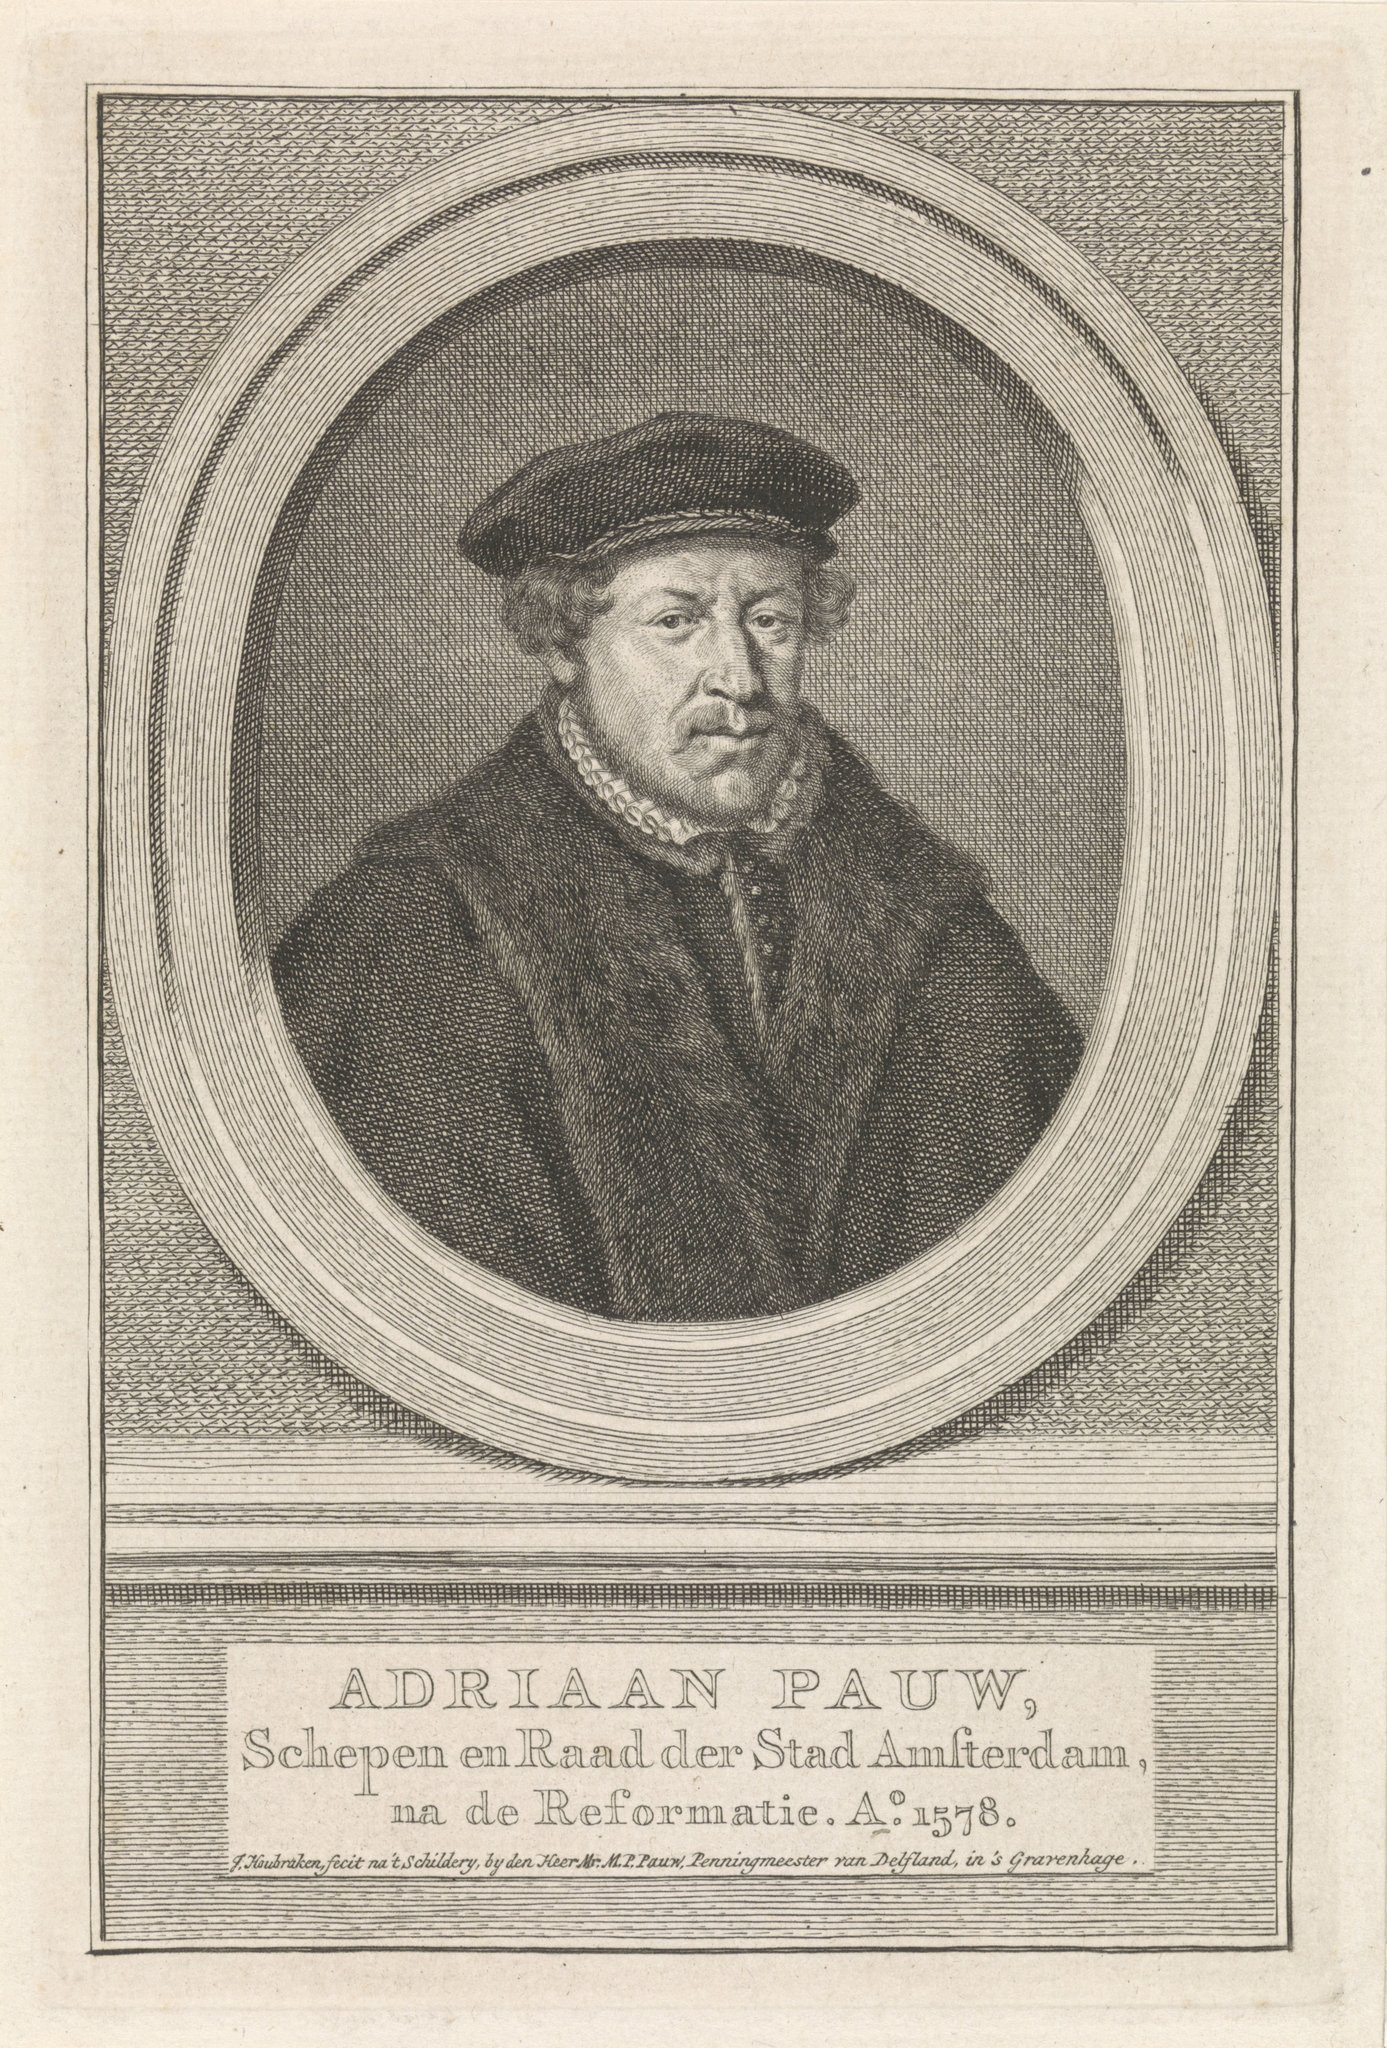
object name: print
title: Portret van Adriaan Pauw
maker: jacob houbraken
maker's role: draughtsman, print maker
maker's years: 1698-1780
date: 1749-1780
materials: paper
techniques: engraving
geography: amsterdam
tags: historical persons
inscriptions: collector's mark: Lugt 2228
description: Deze prent is oorspronkelijk bedoeld als aanvulling op Jan Wagenaars ‘Vaderlandsche historie’* en was zo vanaf 1796 verkrijgbaar bij Johannes Allart te Amsterdam. Voor de advertentie waarin Allart de 60 portretten en 7 platen, allen gegraveerd door Houbraken, ter aanvulling op Wagenaars ‘Vaderlandsche historie’ aanbiedt, zie RP-P-OB-77.766. *Van dit werk zijn in de achttiende eeuw meerdere uitgaves verschenen, zoals: Wagenaar, Jan. Vaderlandsche historie, vervattende de geschiedenissen der Vereenigde Nederlanden (…). 21 delen. Amsterdam: Isaak Tirion, 1749-1759. Wagenaar, Jan. Vaderlandsche historie, vervattende de geschiedenissen der nu Vereenigde Nederlanden (…). 21 delen. Amsterdam: weduwe Isaak Tirion, 1770. Wagenaar, Jan. Vaderlandsche historie, vervattende de geschiedenissen der nu Vereenigde Nederlanden (…). 21 delen. Amsterdam, Leiden, Dordrecht en Harlingen: P. Schouten e.a., 1782. Wagenaar, Jan. Vaderlandsche historie, vervattende de geschiedenissen der nu Vereenigde Nederlanden (…). 21 delen. Amsterdam: Johannes Allart, 1790-1796.